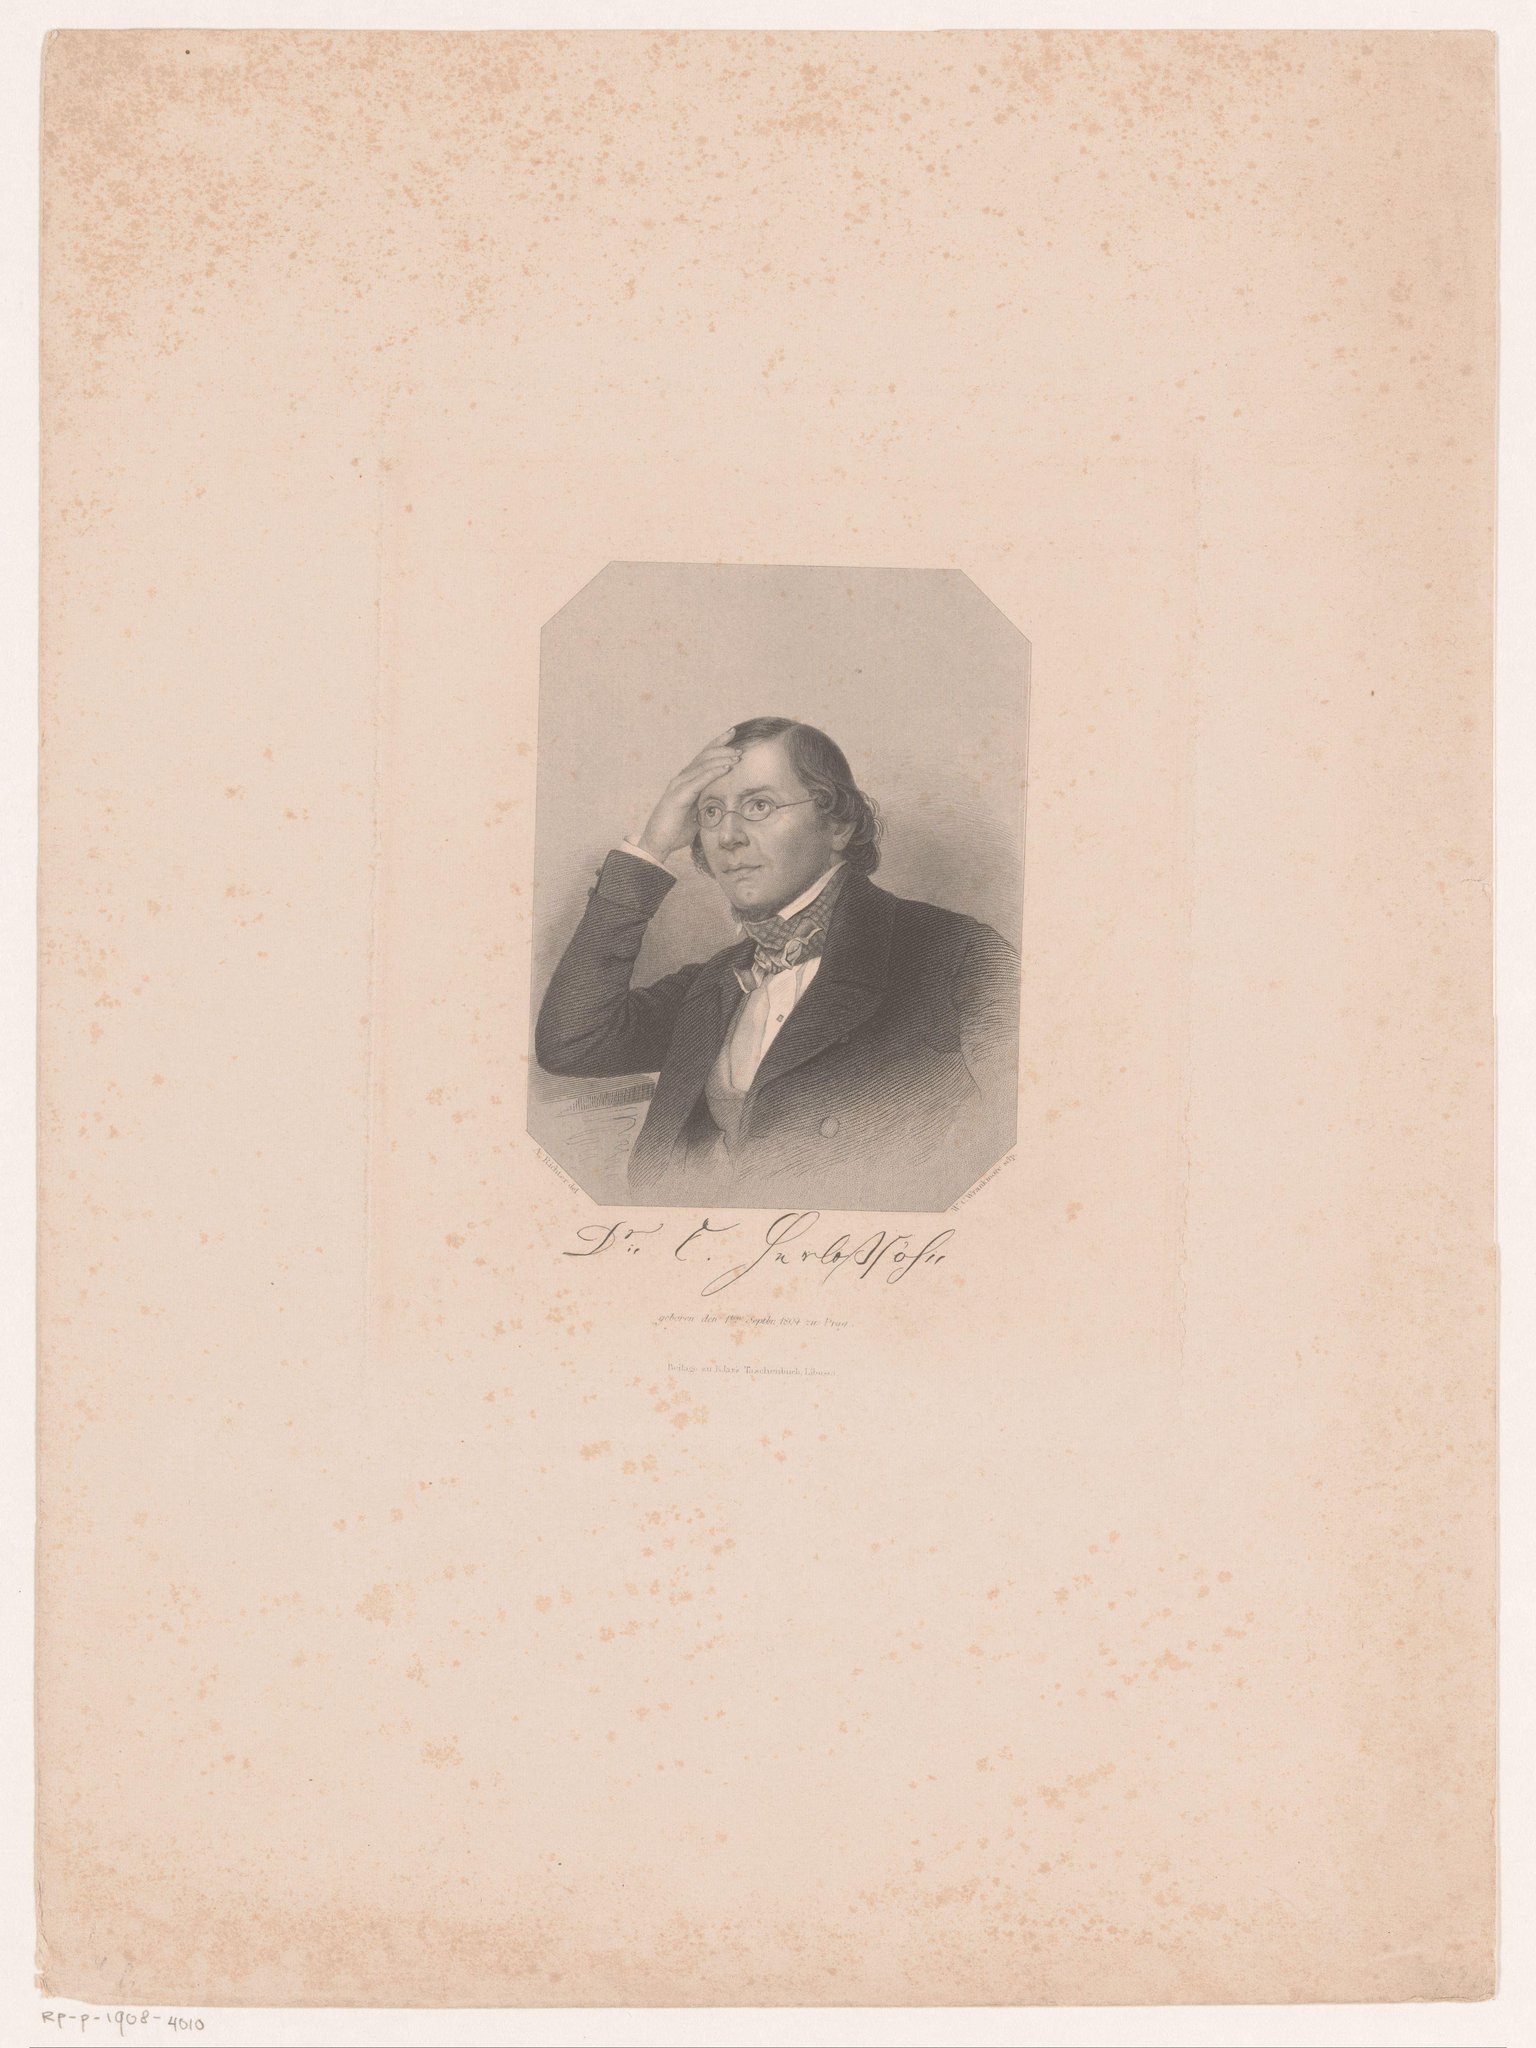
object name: print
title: Portret van Karl Herloßsohn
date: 1826-1840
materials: paper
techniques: engraving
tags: prague, historical persons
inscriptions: collector's mark: Lugt 2228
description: Prent afkomstig uit het jaarboek 'Libussa' van Paul Alois Klar.